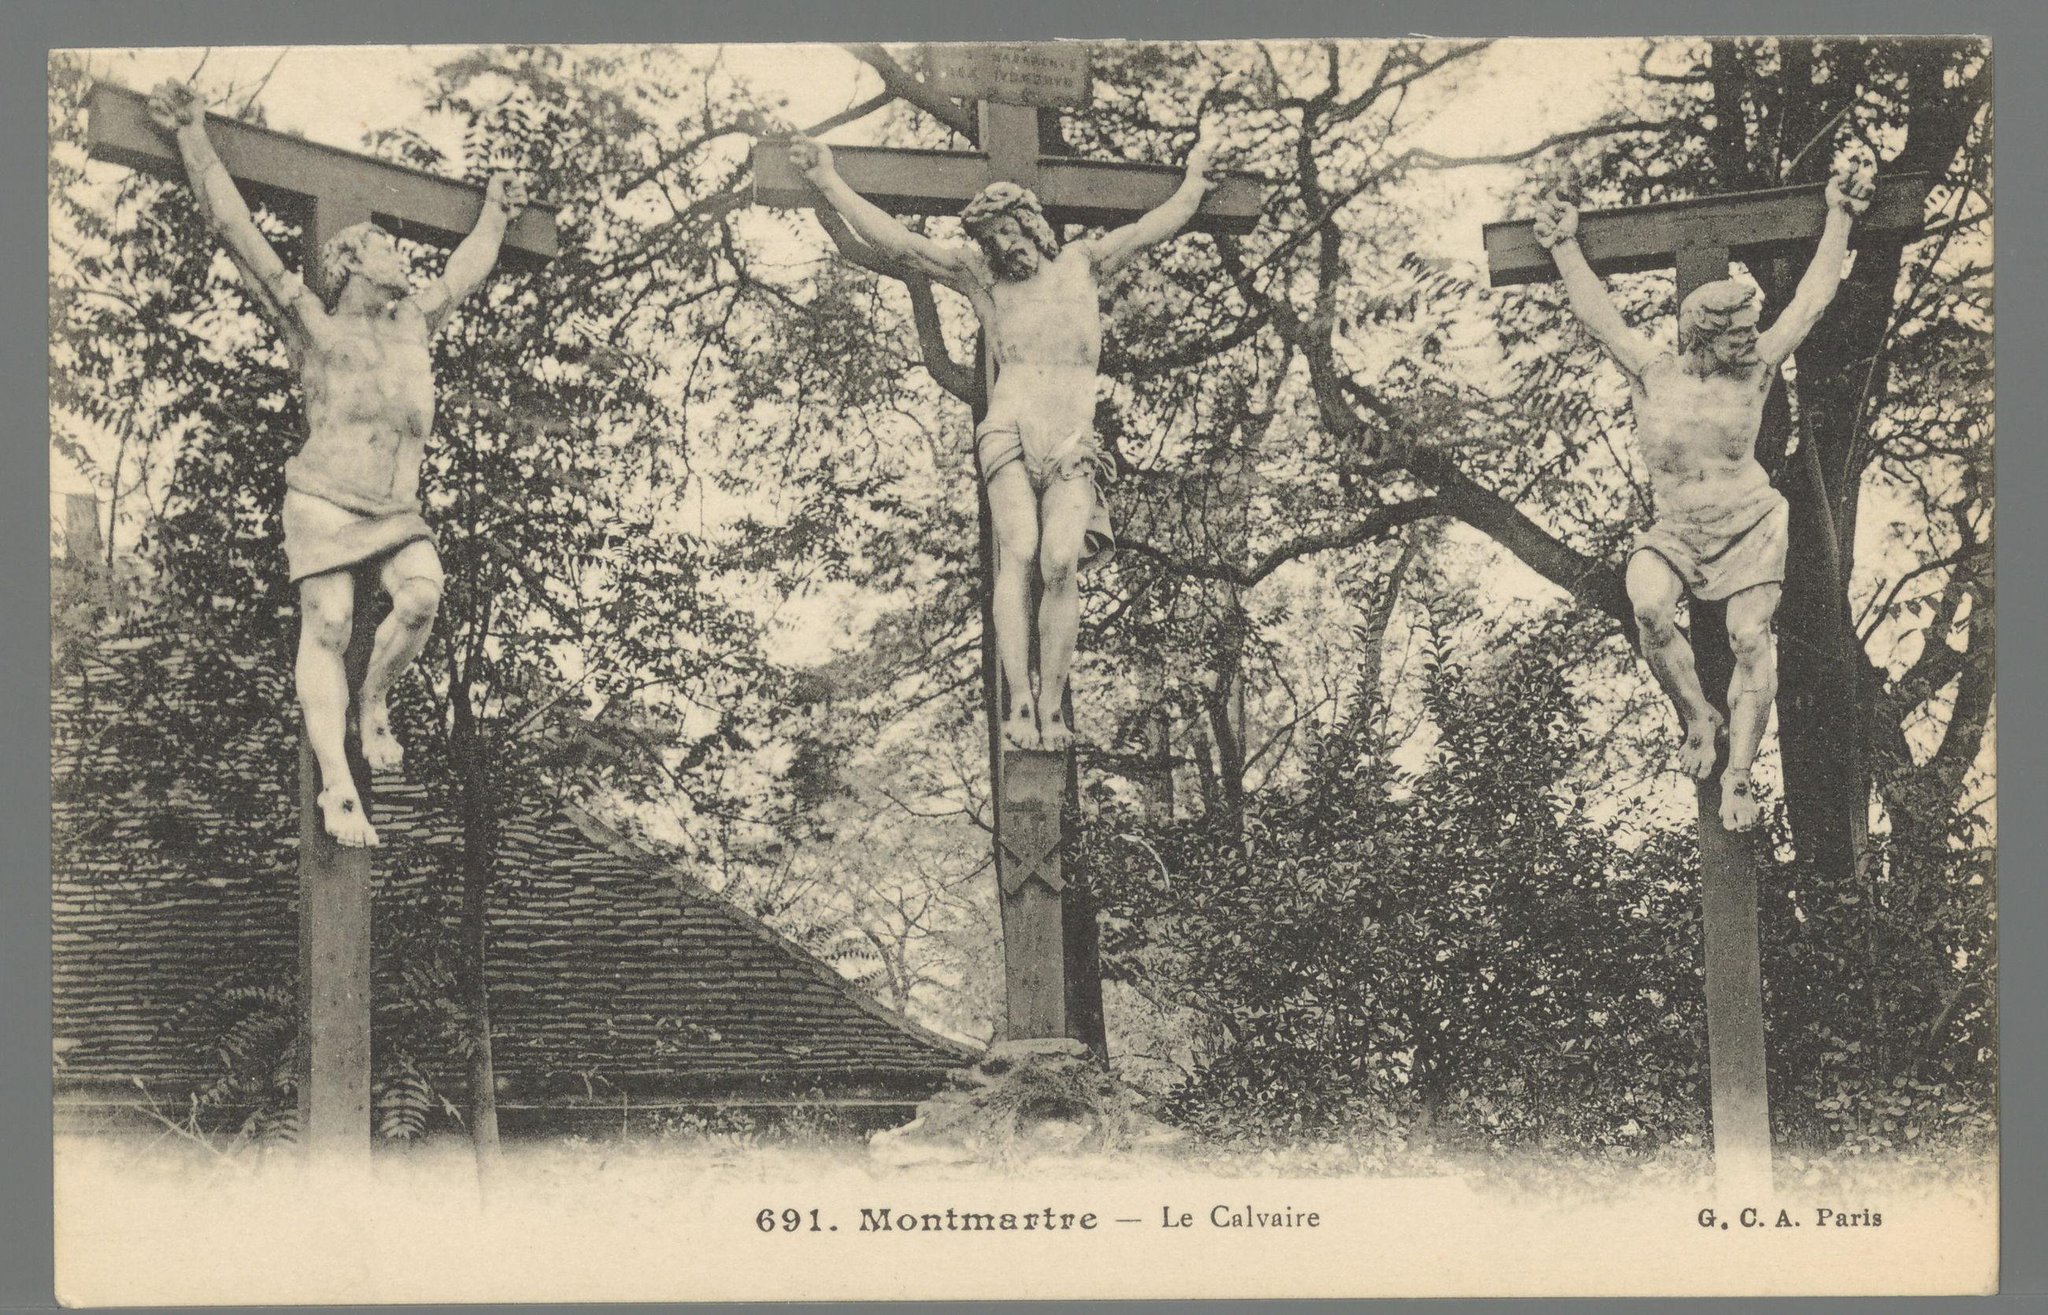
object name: ansichtkaart, prentbriefkaart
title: Montmartre. Le Calvaire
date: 1903-1920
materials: cardboard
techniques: photograph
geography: paris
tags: christ suffering (with crown of thorns, head usually turned sidewards), crucifix ~ personal devotion